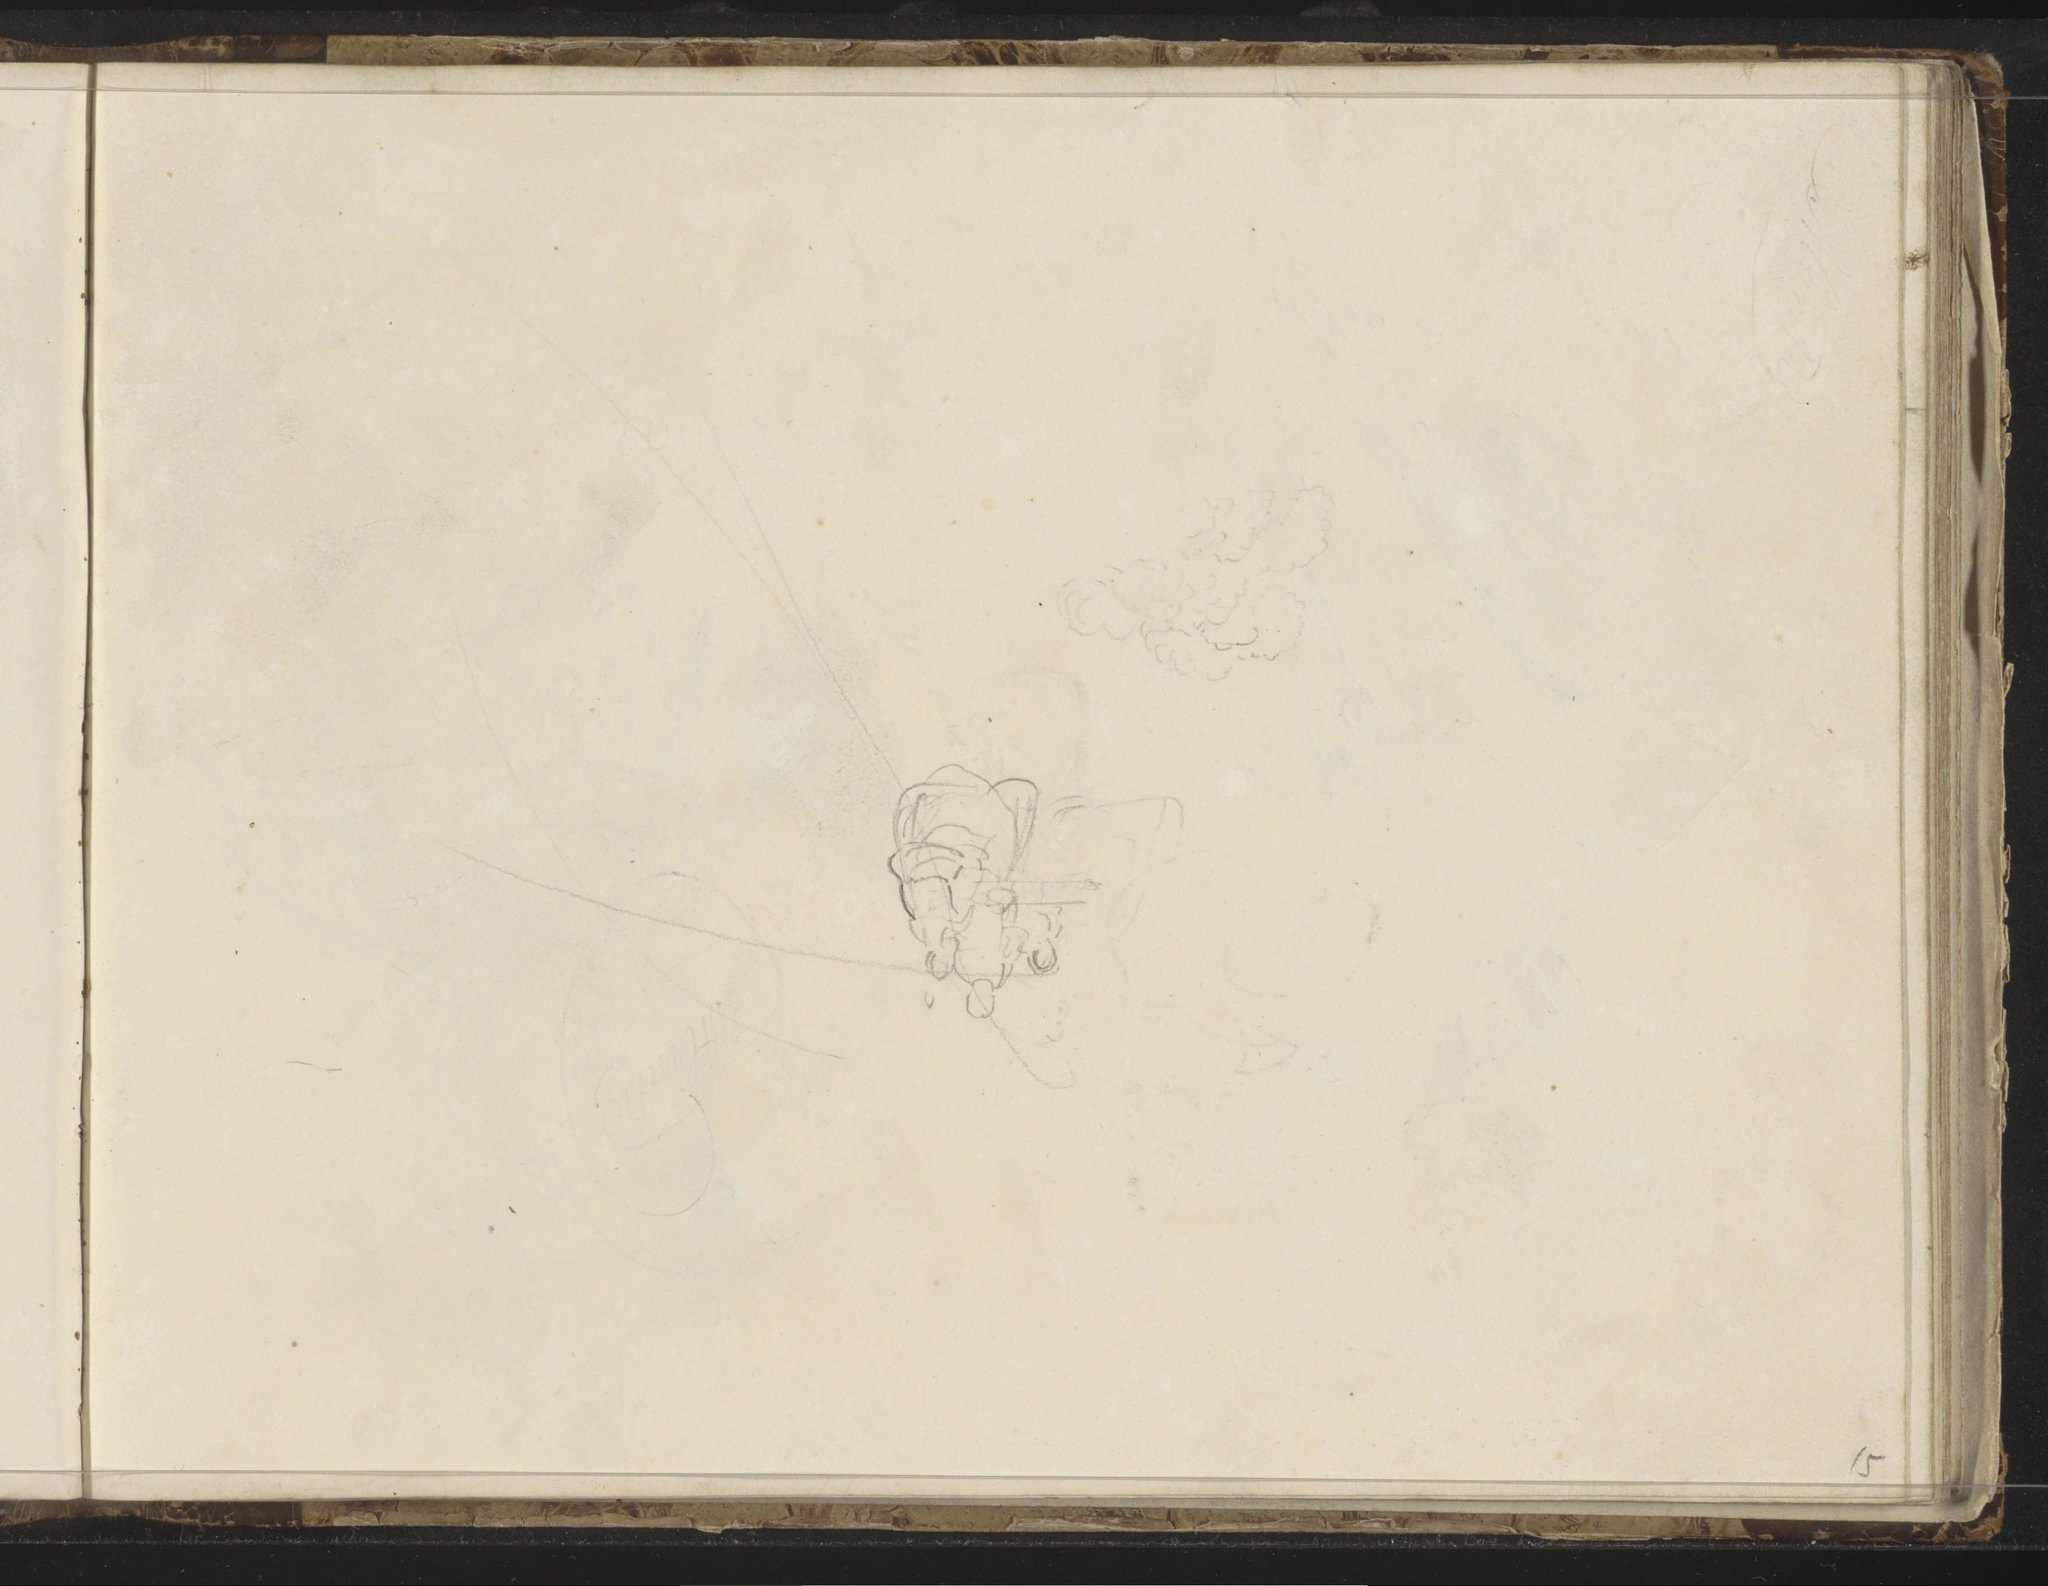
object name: sketchbook leaf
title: Drie figuren en een bladerdek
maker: willem hendrik schmidt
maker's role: draughtsman, painter, print maker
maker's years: 1809-1849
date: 1819-1849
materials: paper, pencil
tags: trees (+ leaf), anatomy (non-medical)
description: Blad 15 recto uit een schetsboek met 52 bladen.